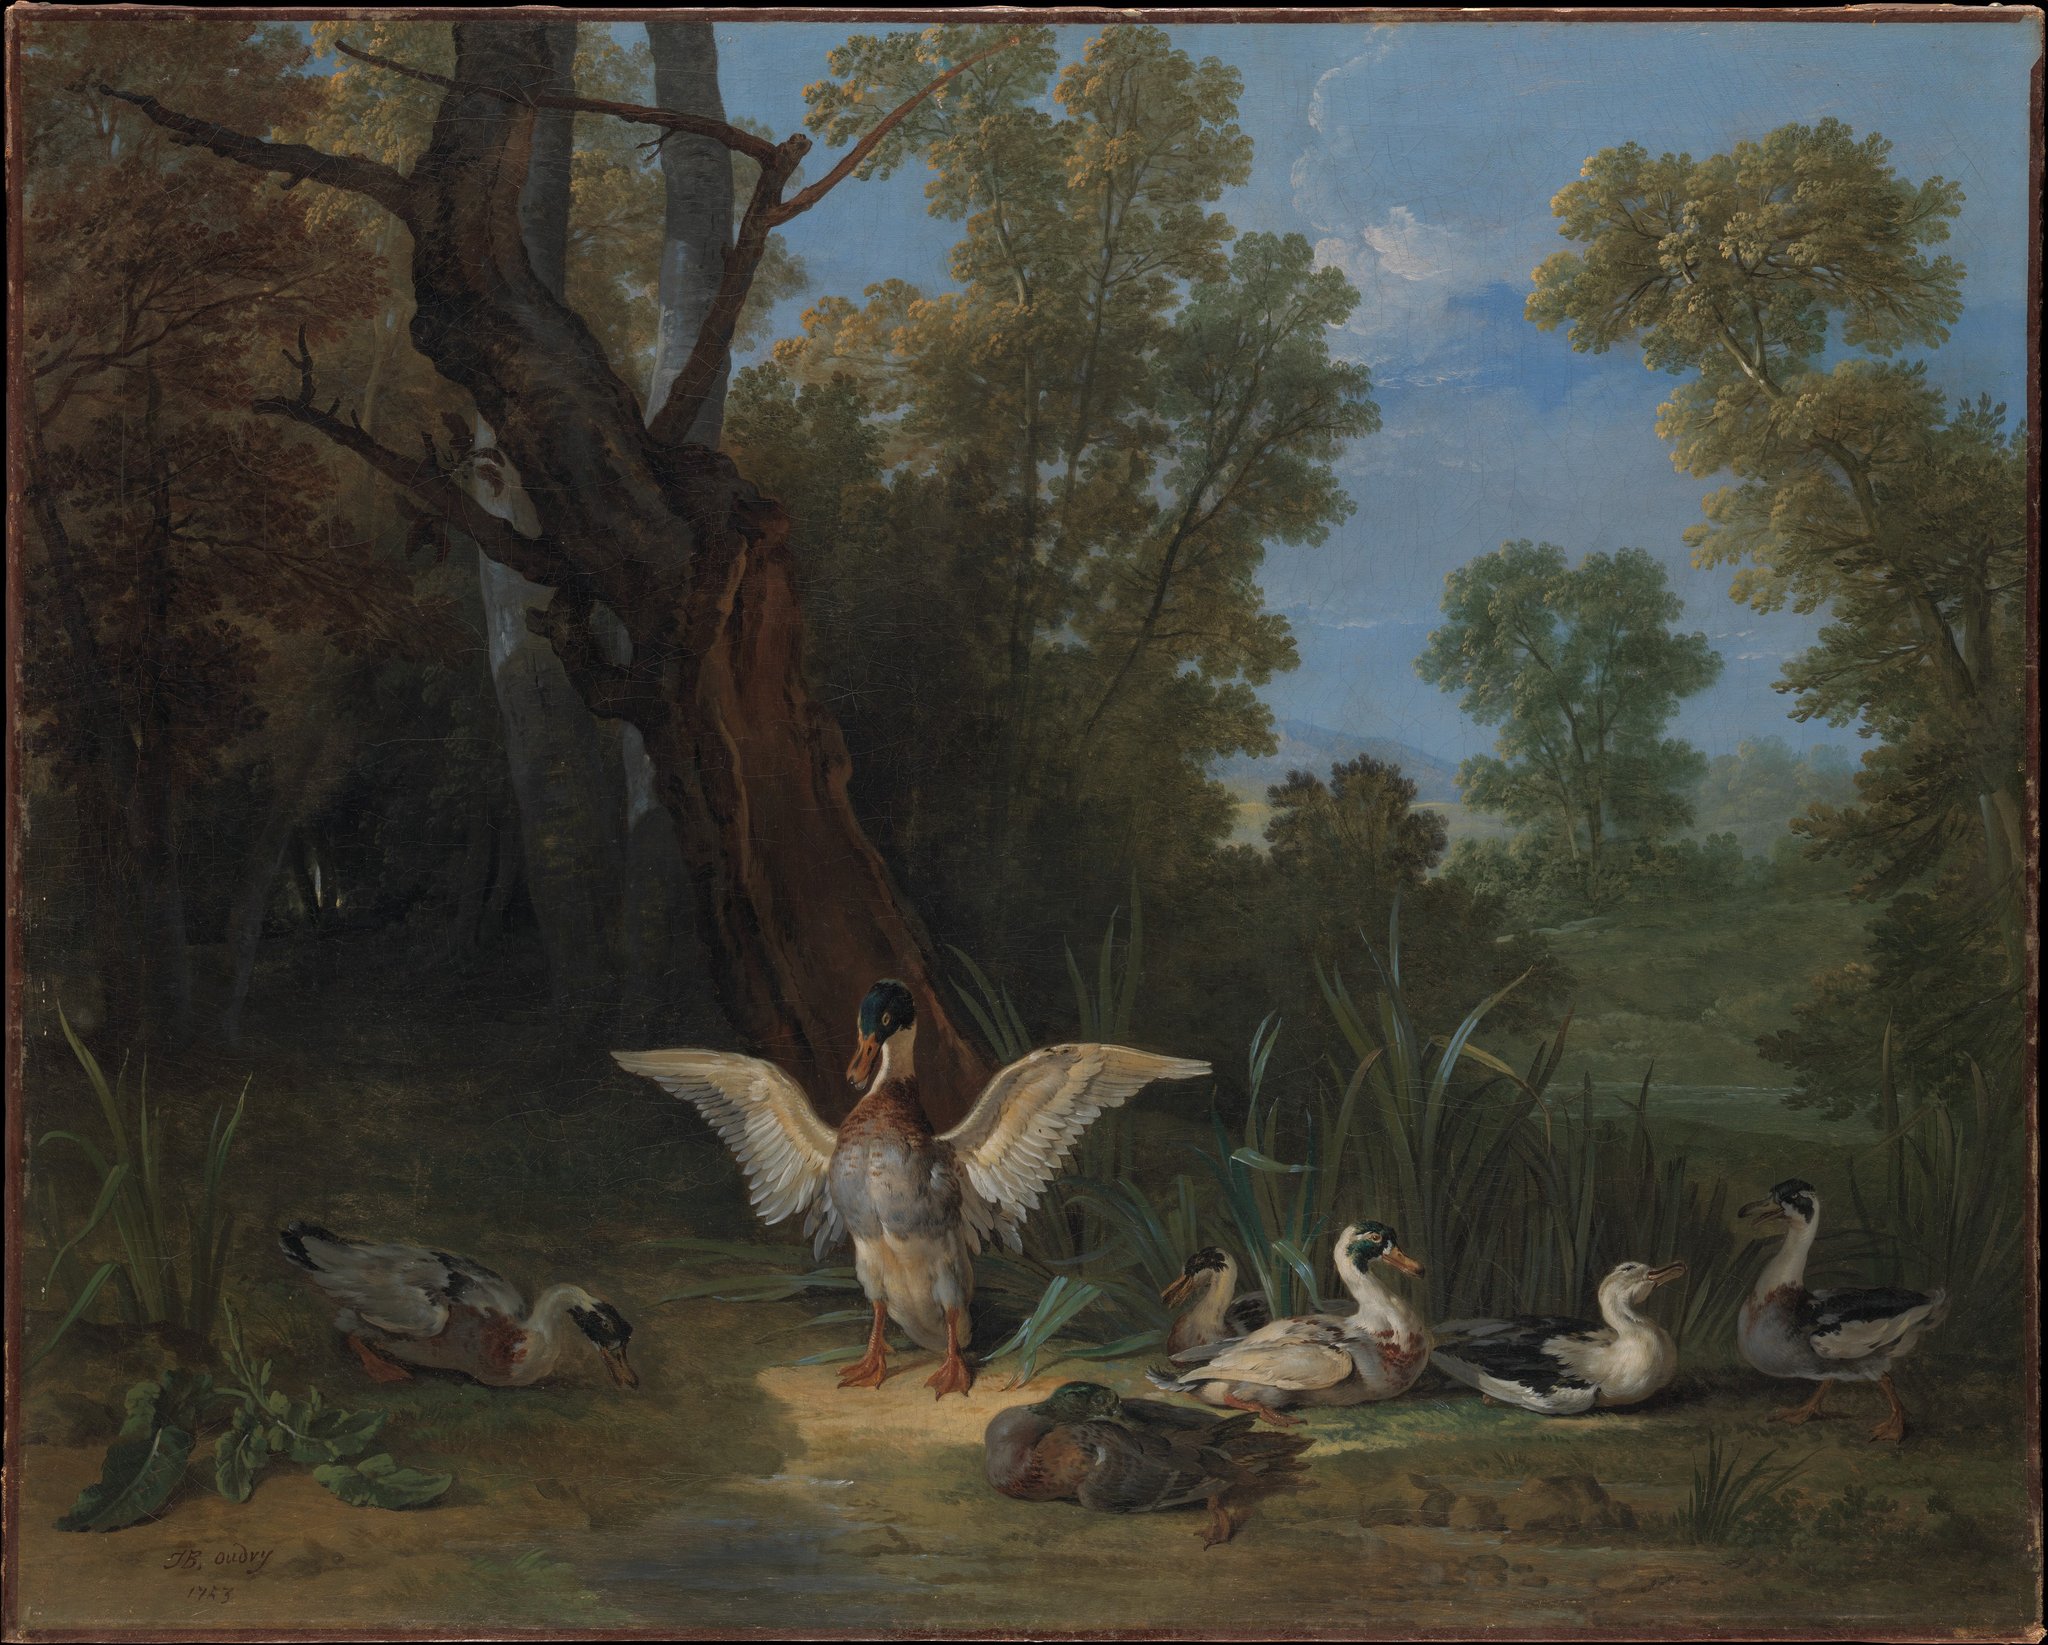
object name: painting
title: Ducks Resting in Sunshine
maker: jean-baptiste oudry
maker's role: artist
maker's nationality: french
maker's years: 1686-1755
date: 1753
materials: canvas, oil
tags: ducks,landscapes